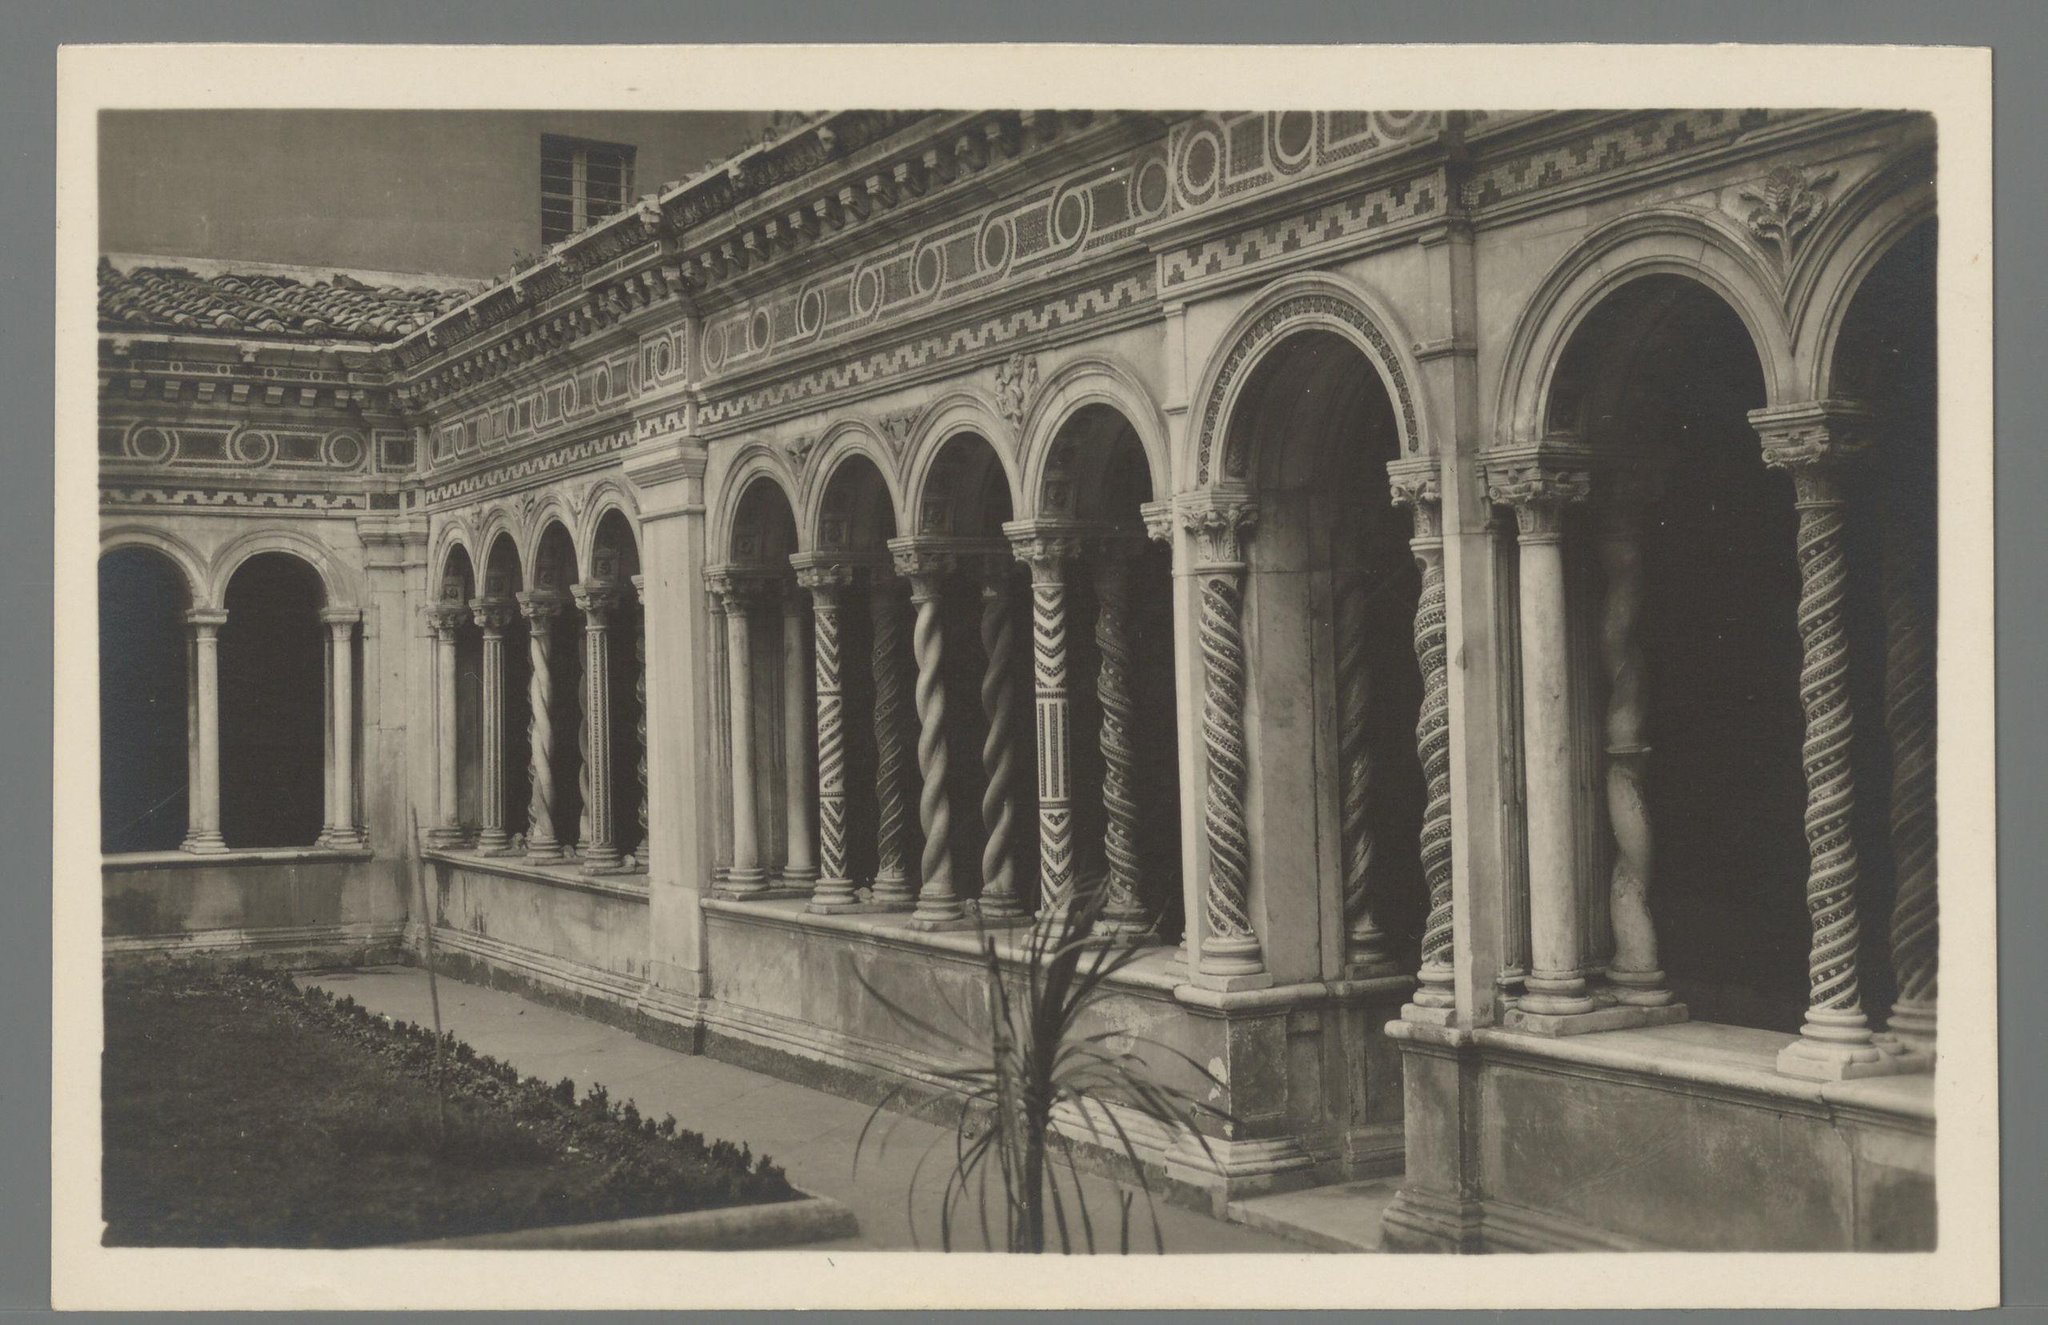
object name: ansichtkaart, prentbriefkaart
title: Roma. Chiostro di S. Paolo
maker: Anonymous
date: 1931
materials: photographic support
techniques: photography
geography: rome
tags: cloisters ~ monastery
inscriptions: date